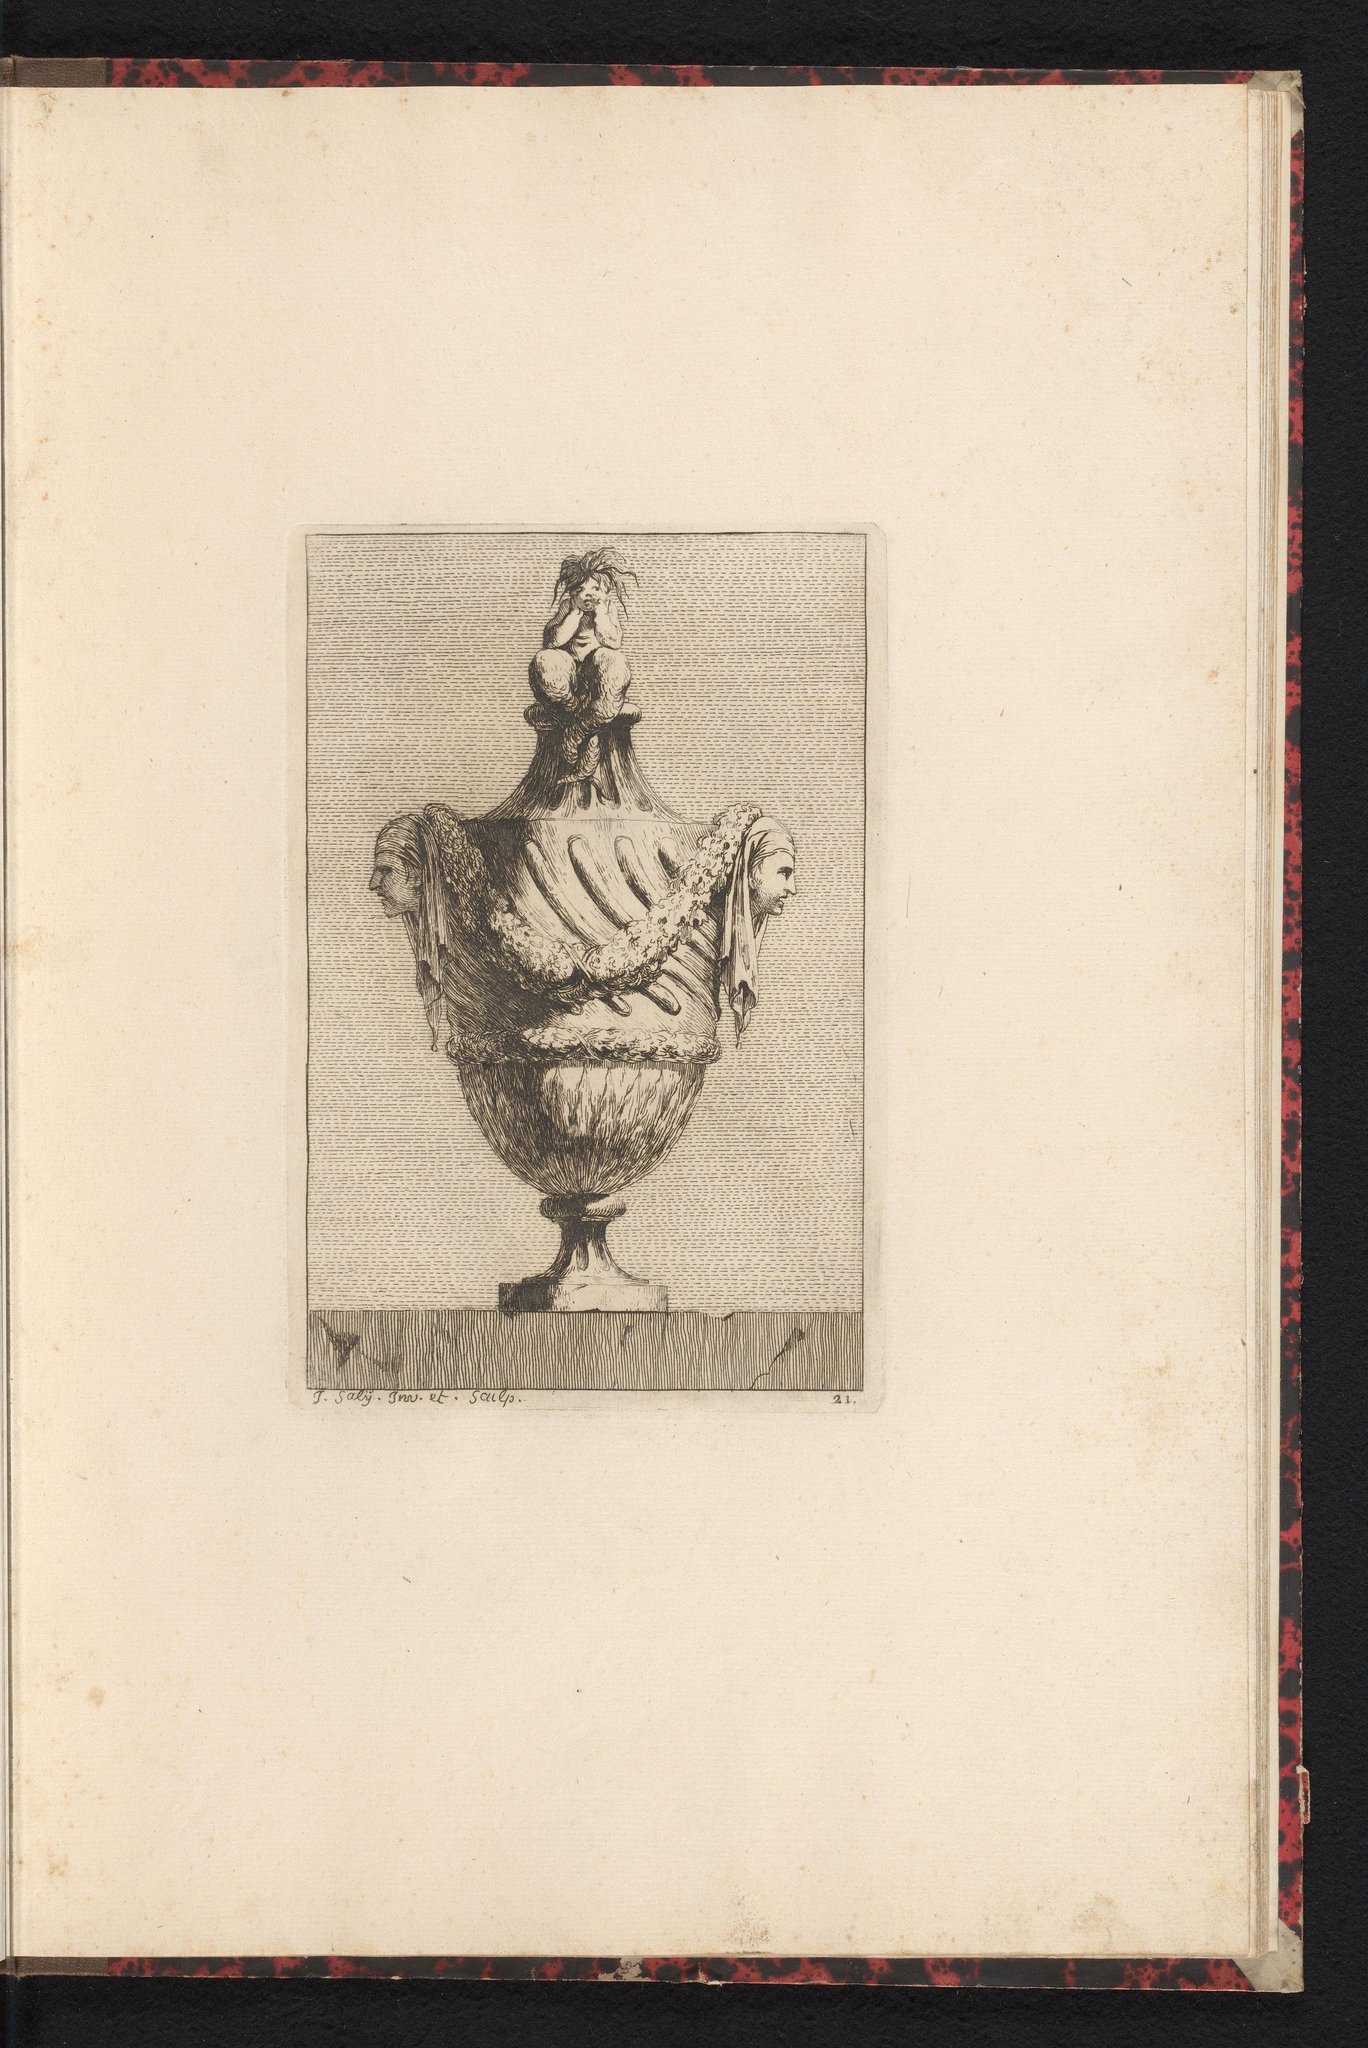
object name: ornament print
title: Vasa a se inventa atq. studii causa delin. et incisa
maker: jacques francois joseph saly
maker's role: print maker, sculptor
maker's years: 1717-1776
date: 1746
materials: paper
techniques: etching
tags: merman, mask, mascaron ~ ornament, ornament ~ festoon, garland, garden vase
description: Deze prent maakt deel uit van een album.